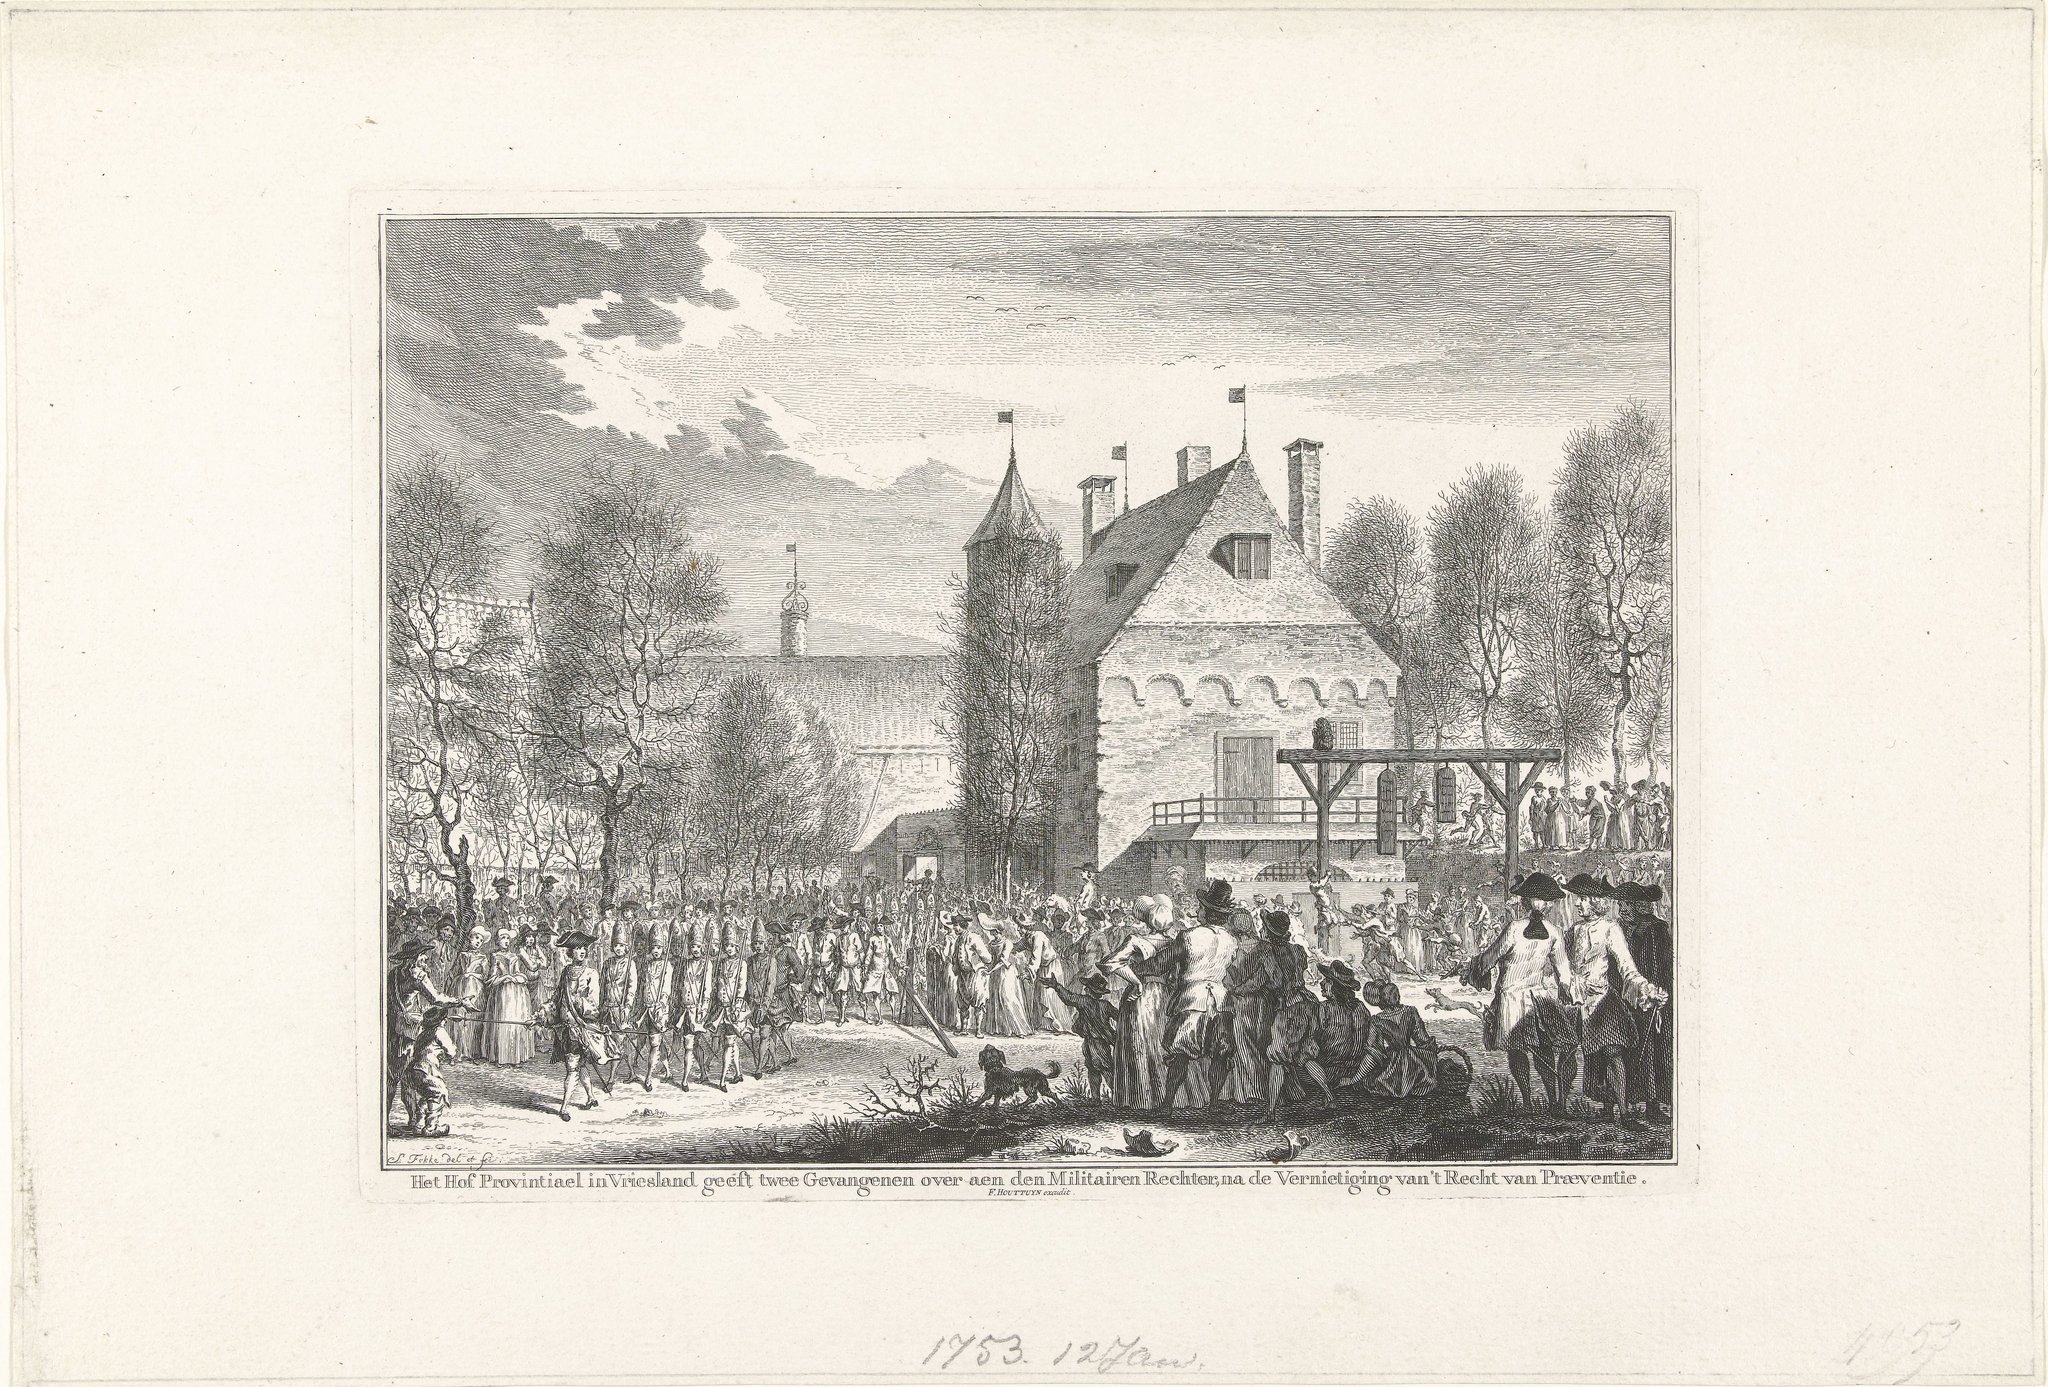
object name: print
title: Het Hof Provintiael in Vriesland geeft twee Gevangenen over aen den Militairen Rechter, na de Vernietiging van 't Recht van Praeventie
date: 1753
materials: paper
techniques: engraving, etching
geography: northern netherlands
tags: lower house, parliament, chamber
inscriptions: collector's mark: Lugt 2228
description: Overdracht door het Provinciale Hof van Friesland te Leeuwarden van twee gevangenen aan de militaire rechter, 12 januari 1753. De gevangenen worden onder grote publieke belangstelling door een militaire escorte weggeleid. Rechts voor de Kanselarij een schavot en galg.